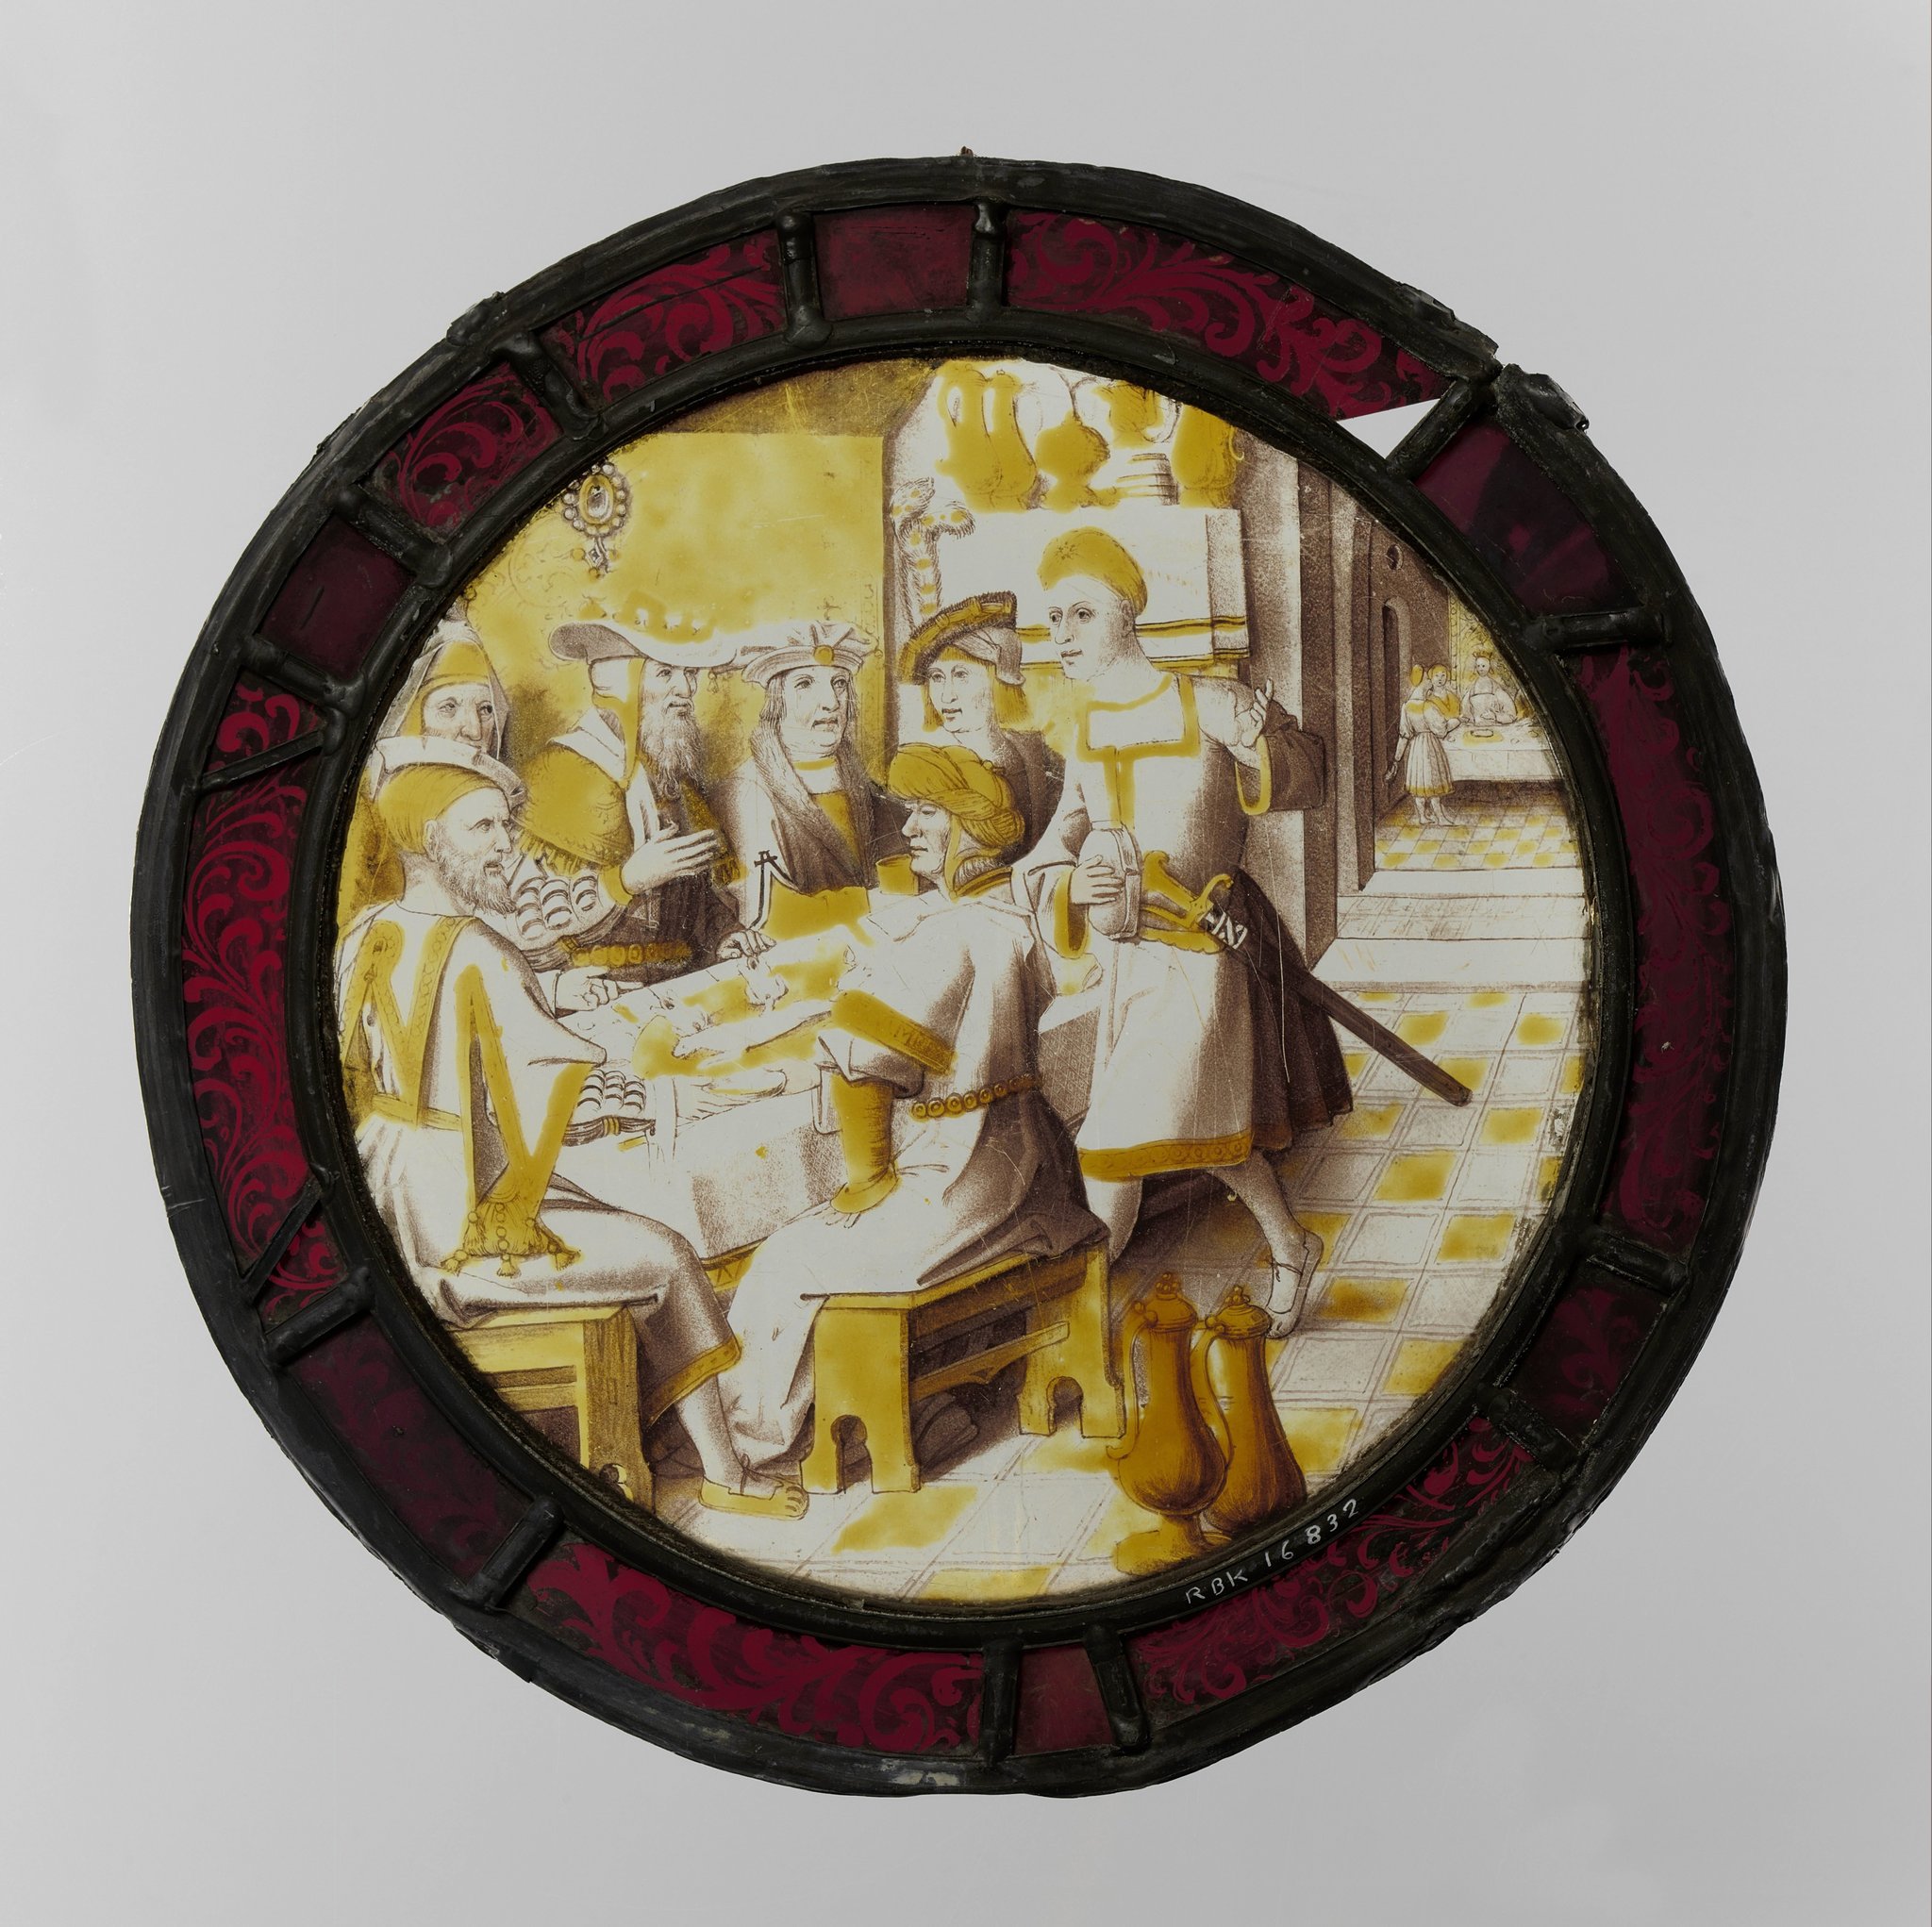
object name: light window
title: Ruit met feestmaal van Ahasveros en koningin Vasthi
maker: Anonymous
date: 1525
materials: glass, lead, pigment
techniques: leading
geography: northern netherlands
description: Ronde gebrandschilderde ruit in grisaille en zilvergeel met de voorstelling van de feestmalen van koning Ahasveros en koningin Vasthi. Met in de rand rankenornament in rood.